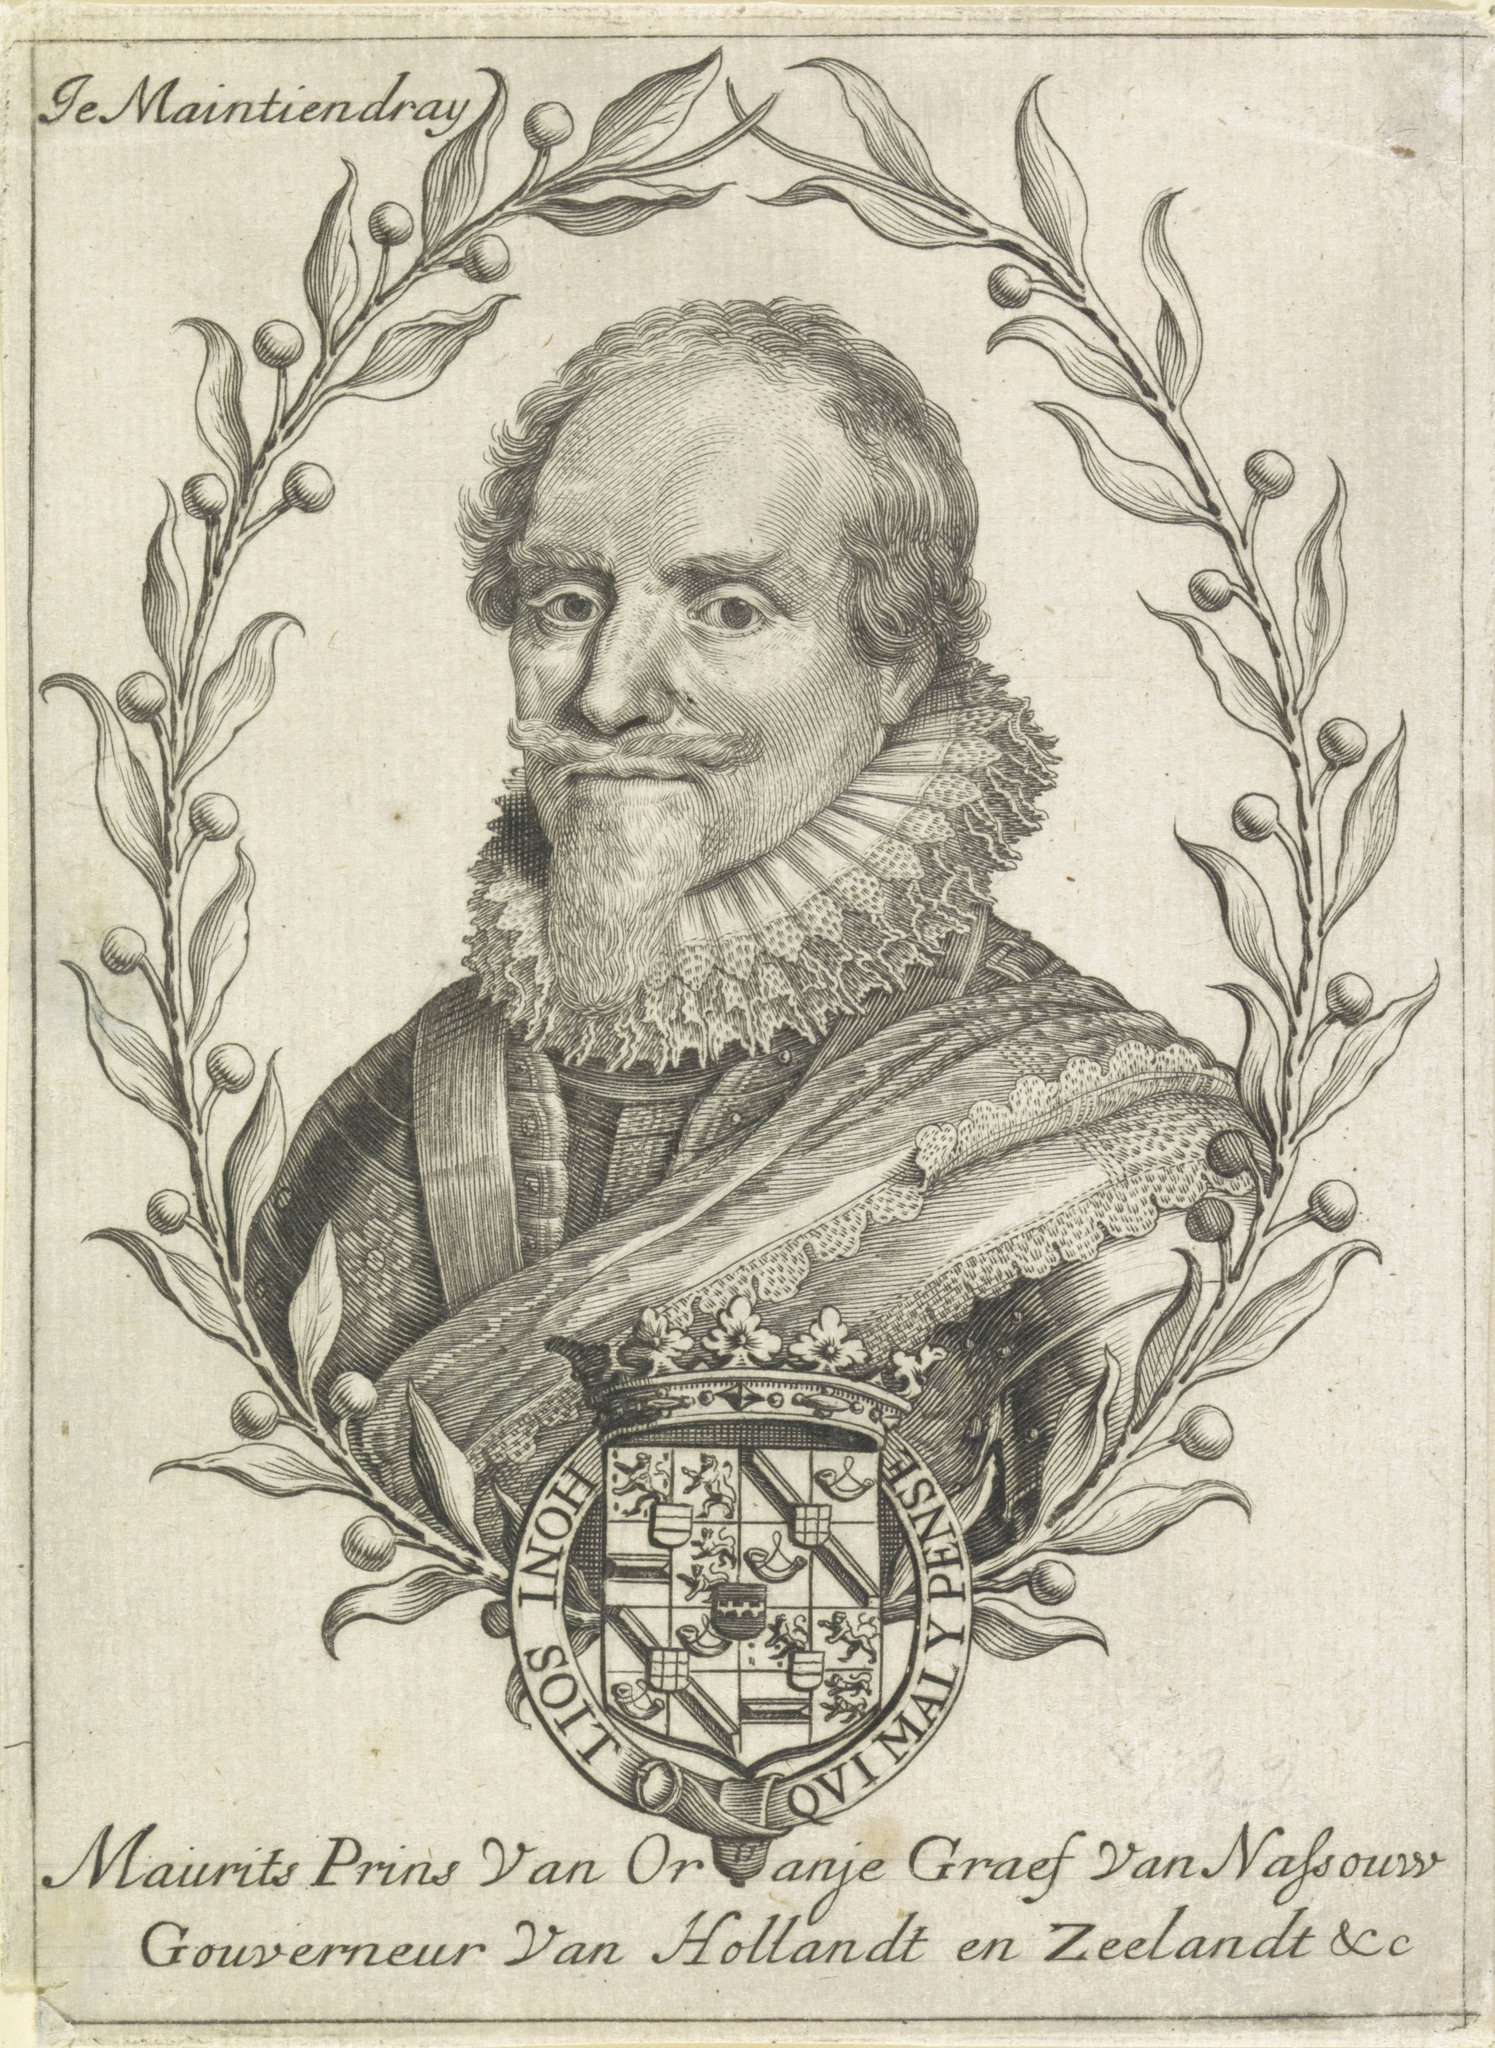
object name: print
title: Portret van Maurits, prins van Oranje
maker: Anonymous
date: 1650-1749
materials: paper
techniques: engraving, etching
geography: low countries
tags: the hague, maurice (prince of orange), knighthood order (garter) - insignia of a knighthood order, e.g.: badge, chain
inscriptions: collector's mark: Lugt 963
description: Portret van Maurits in een ovaal van oranjetakken. Midden onder zijn wapen met een kroon, gedecoreerd met de Kousenband en het devies van de Orde van de Kousenband. Linksboven zijn geslachtsspreuk. In de ondermarge zijn naam.